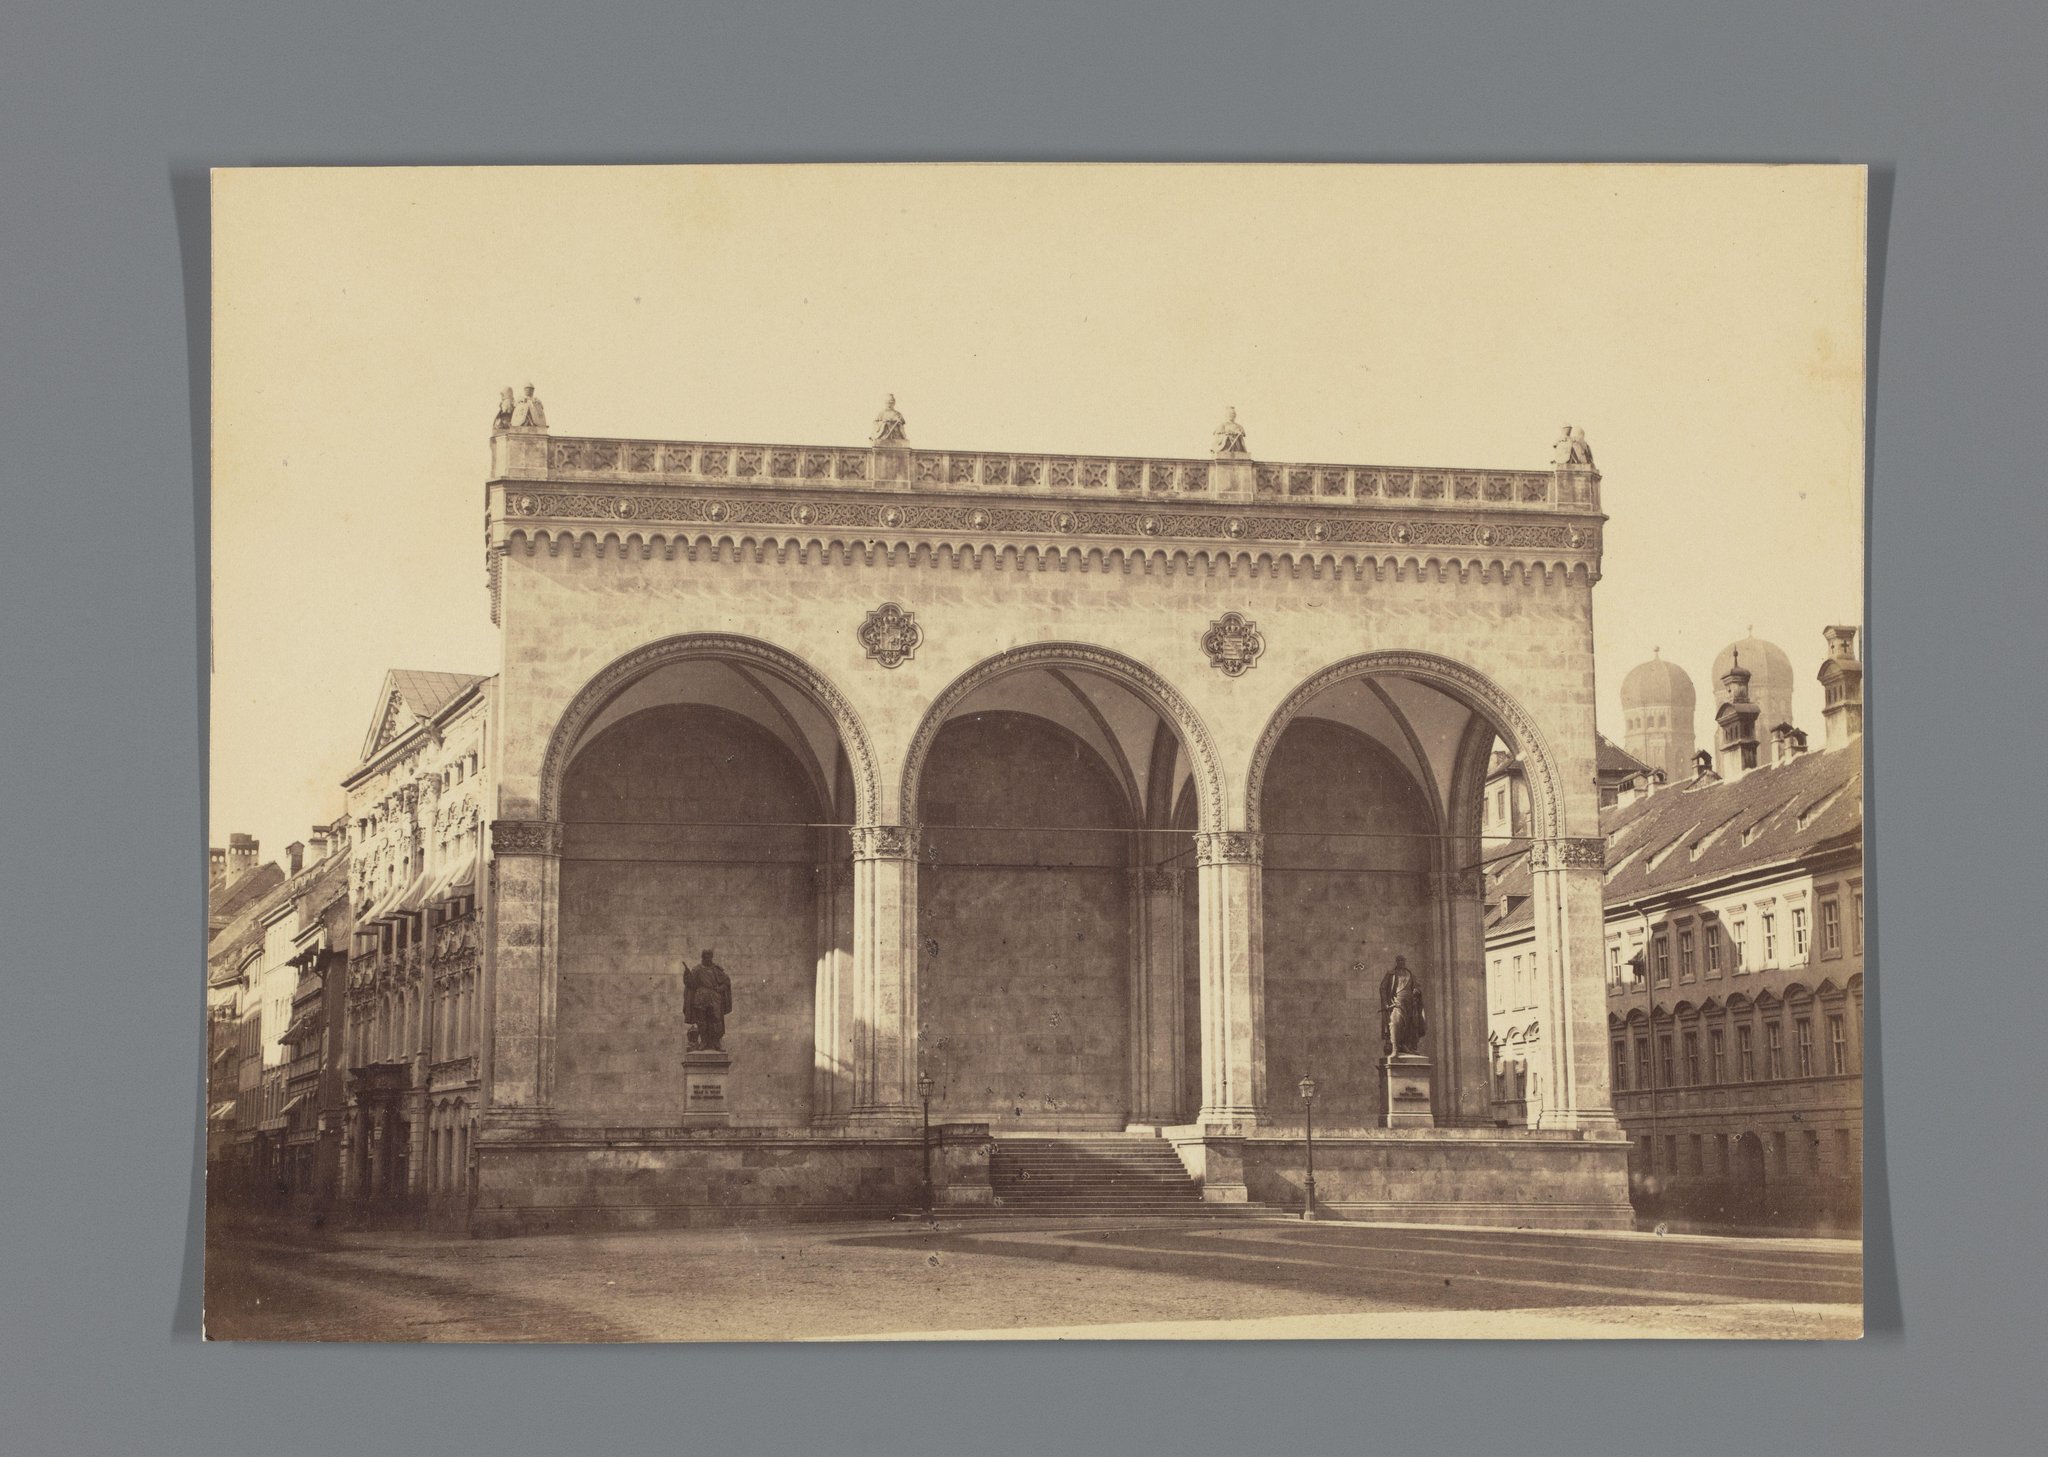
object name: photograph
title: München Feldherrnhalle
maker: Anonymous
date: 1850-1900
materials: cardboard, photographic support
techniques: albumen print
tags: feldherrnhalle